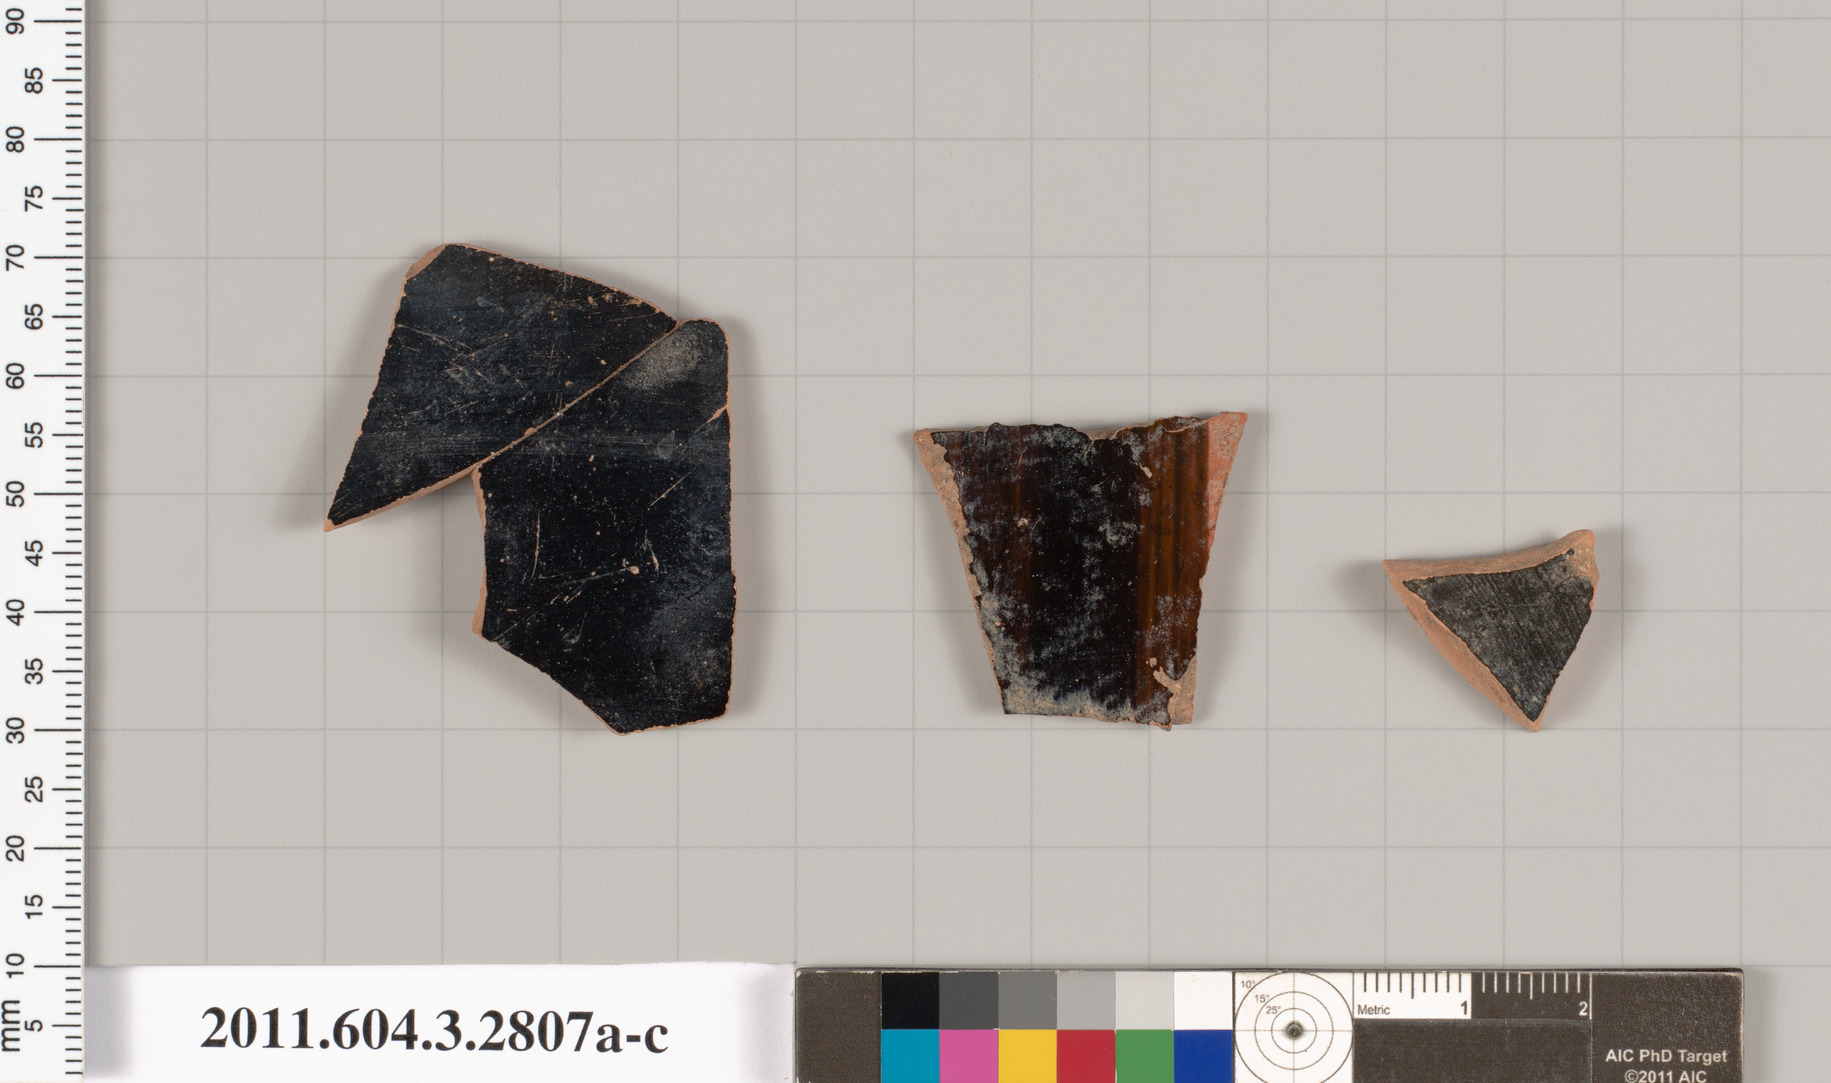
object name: oinochoe or olpe fragment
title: Terracotta fragments of oinochoai (jugs) or olpai (jugs)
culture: greek, attic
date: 600-401 BCE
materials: terracotta